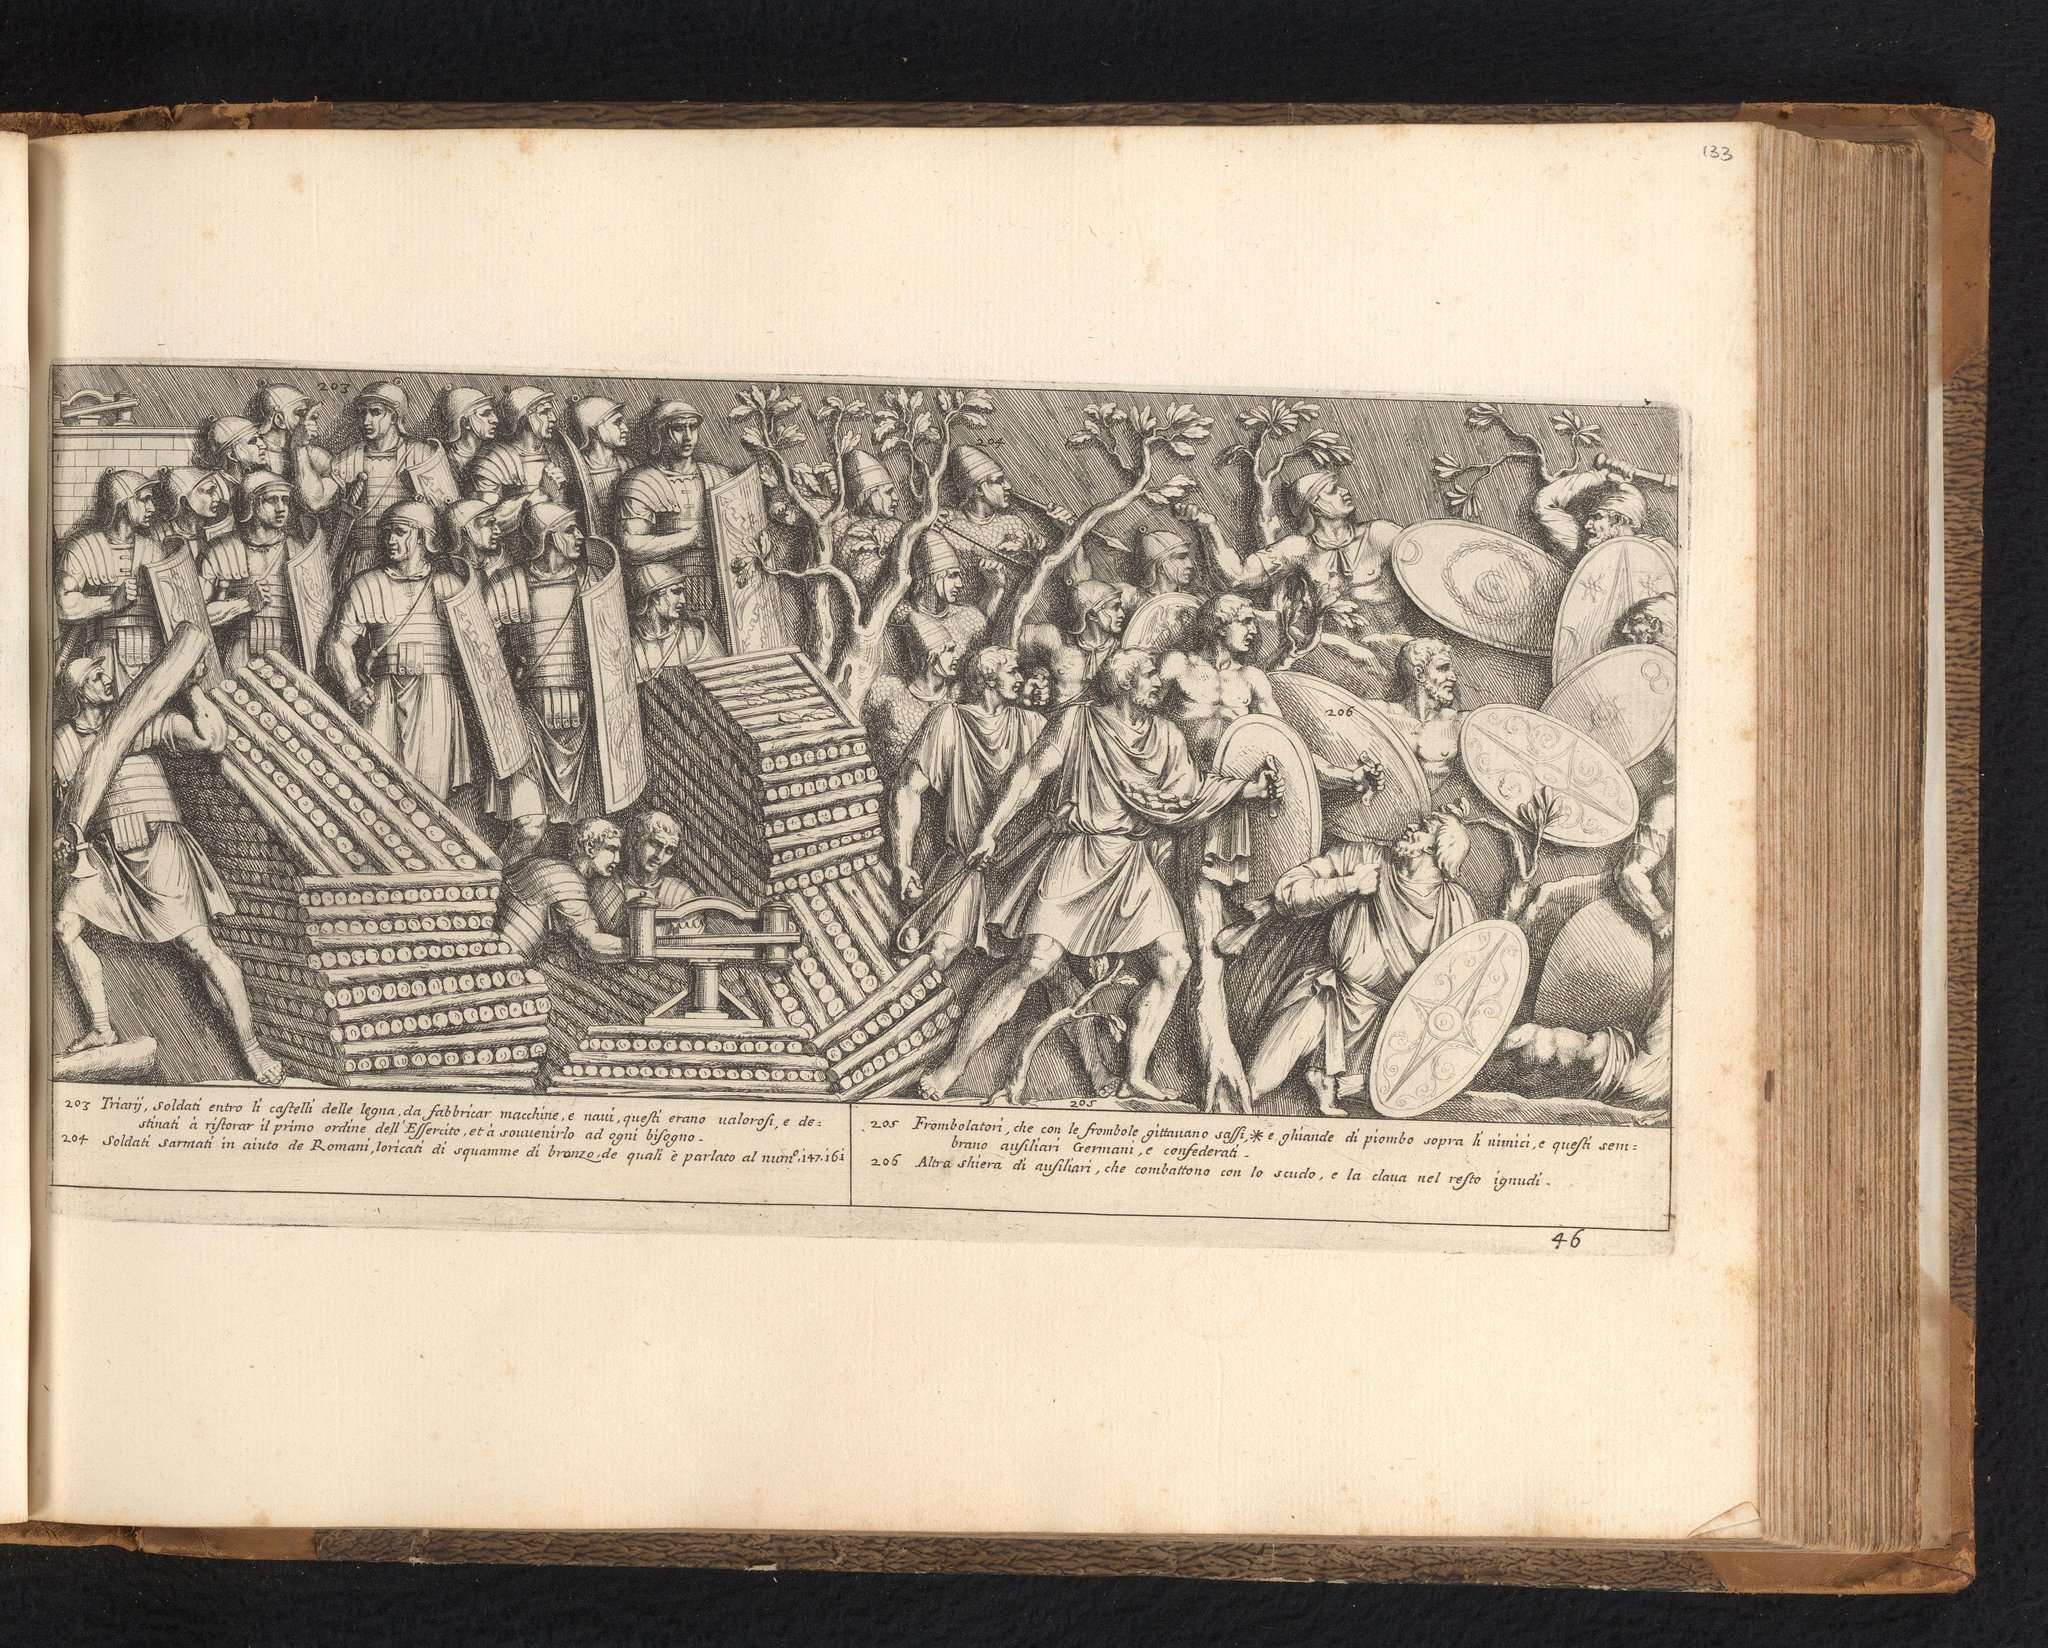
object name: print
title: Zuil van Trajanus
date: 1637-1691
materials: paper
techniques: etching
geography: rome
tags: triumphal column with helical friezes, piece of sculpture, reproduction of a piece of sculpture, the soldier; the soldier's life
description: Detail van het spiraalvormige gebeeldhouwde fries op de Zuil van Trajanus. Het fries toont de oorlogen tussen de Romeinen en de Daciërs. Verklarende nummers in de ondermarge. Prent maakt deel uit van een album.